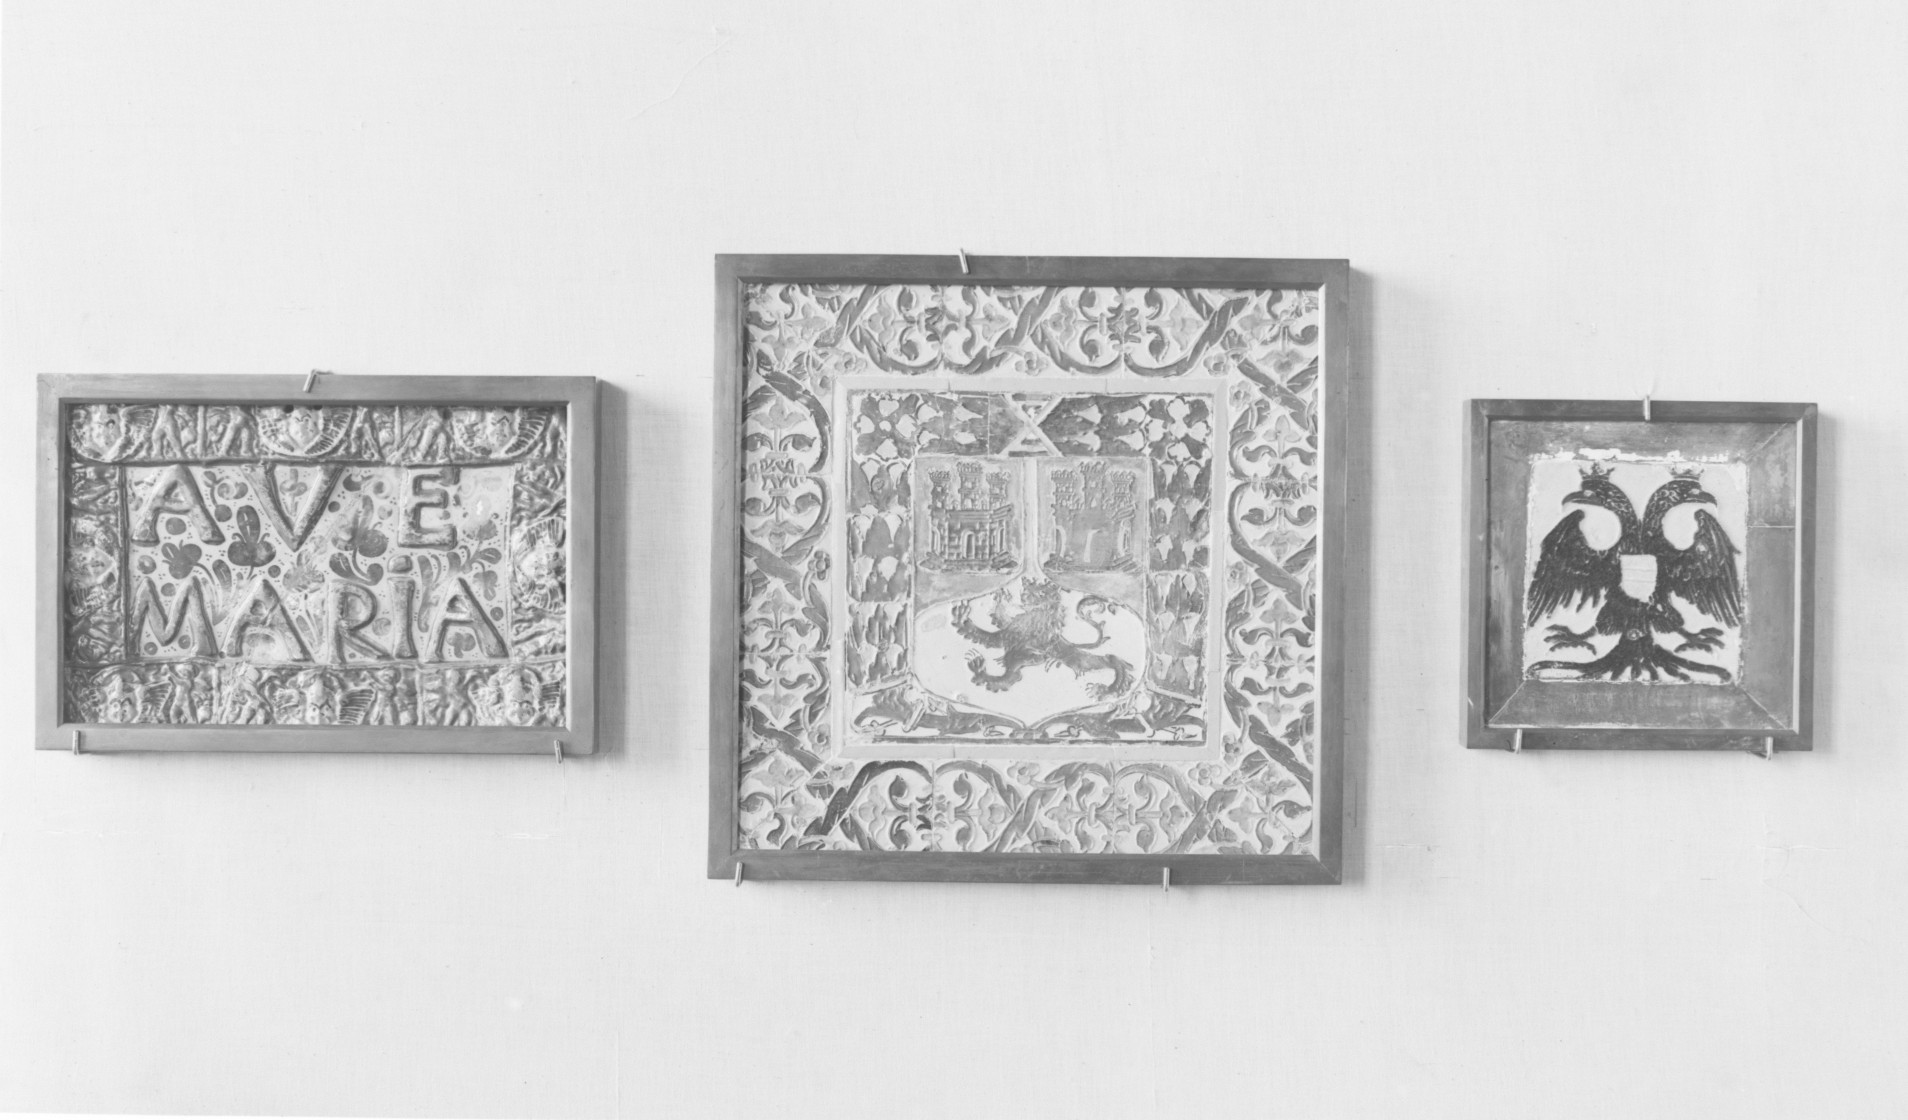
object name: wall tile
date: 1501-1600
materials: earthenware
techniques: glazing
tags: coat of arms